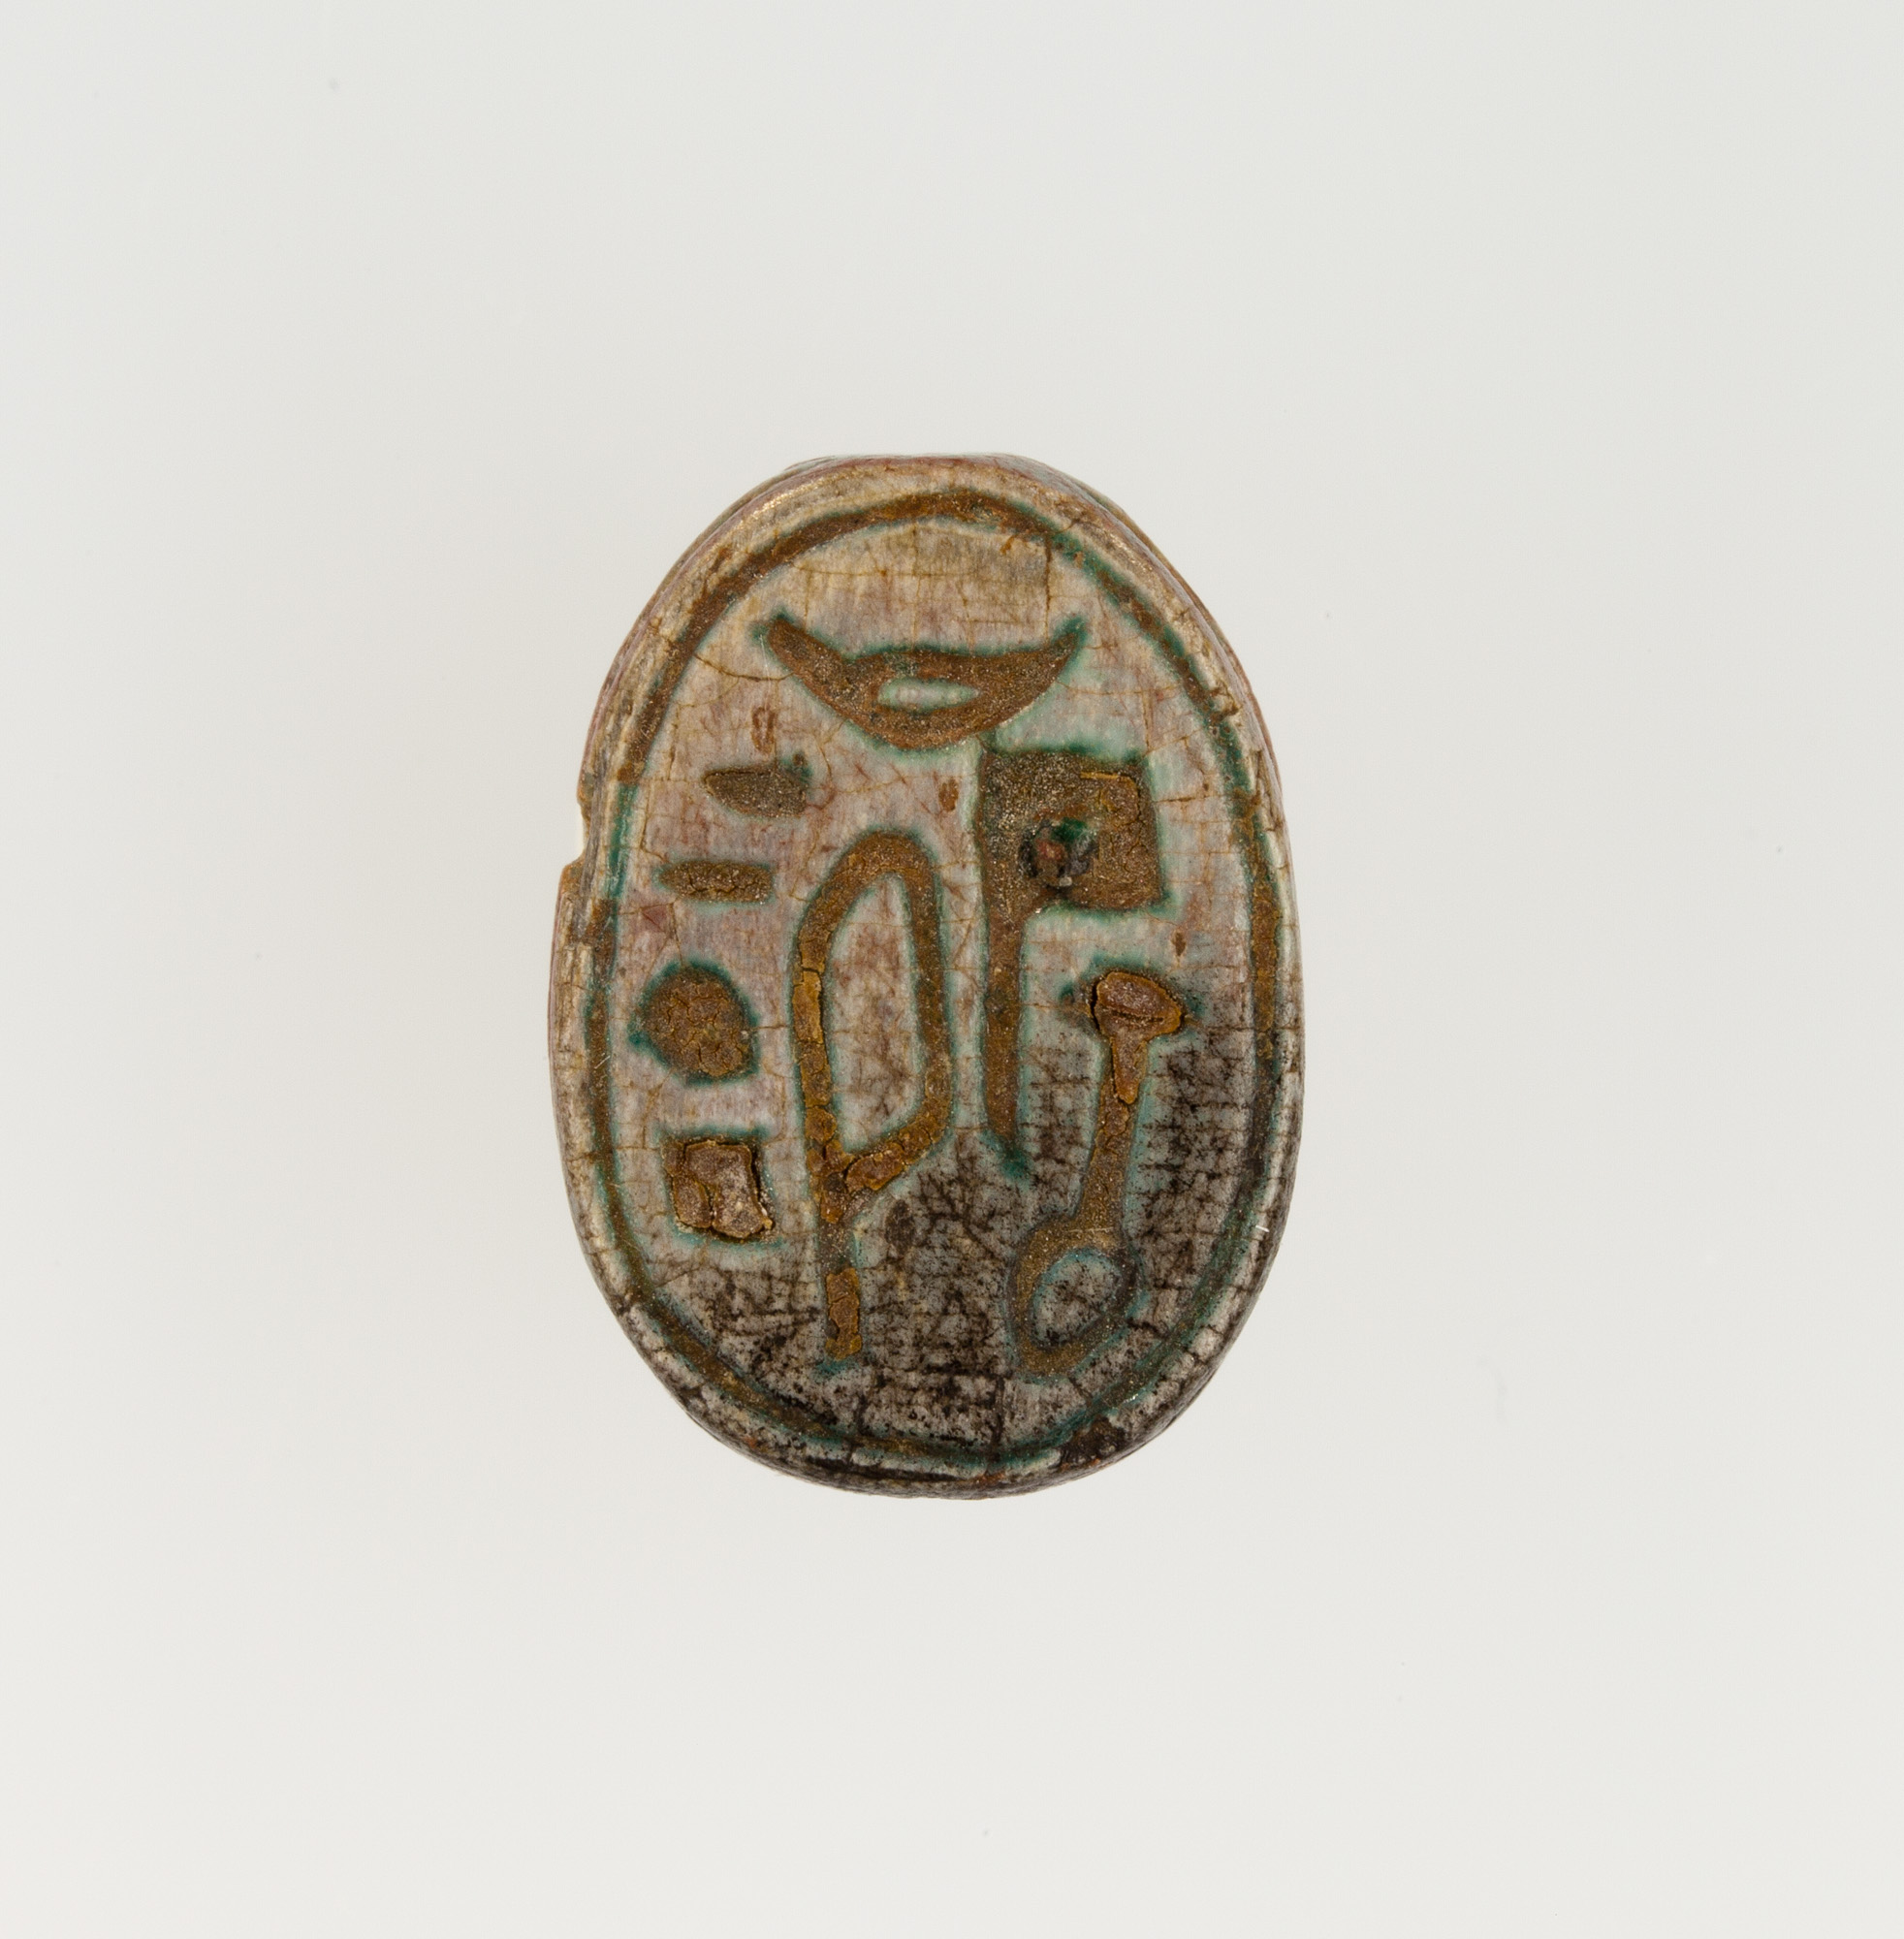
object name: scarab, ahmose nefertari, god's wife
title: Scarab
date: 1550-1525 BCE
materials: stone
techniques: glazing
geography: egypt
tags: scarabs